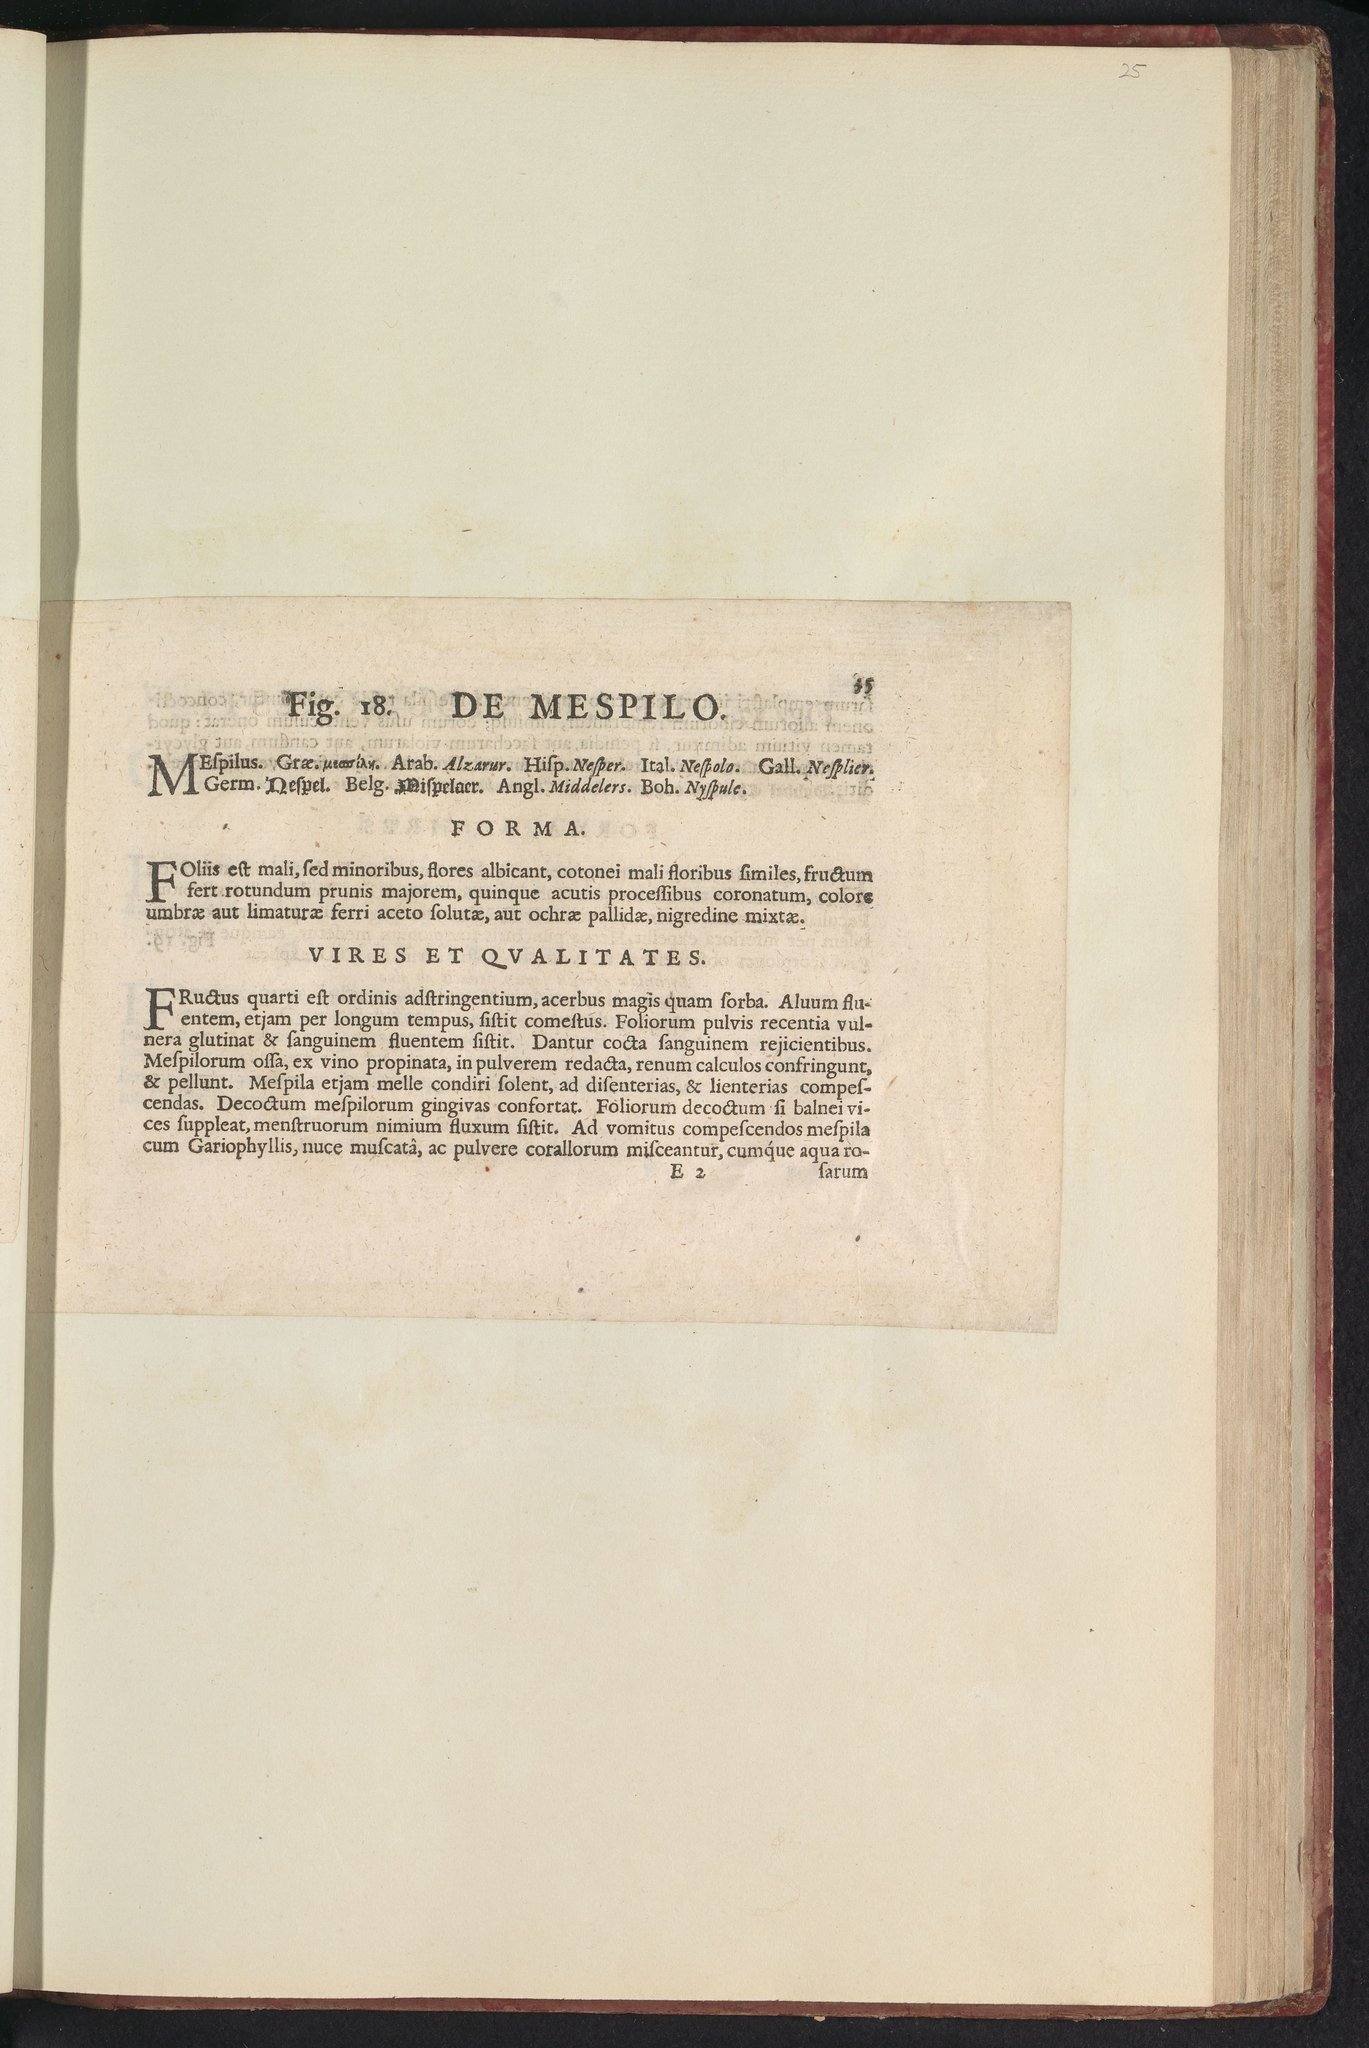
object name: text sheet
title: Fig. 18 'De Mespilo' in De Boodts herbarium van 1640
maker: anselmus boëtius de boodt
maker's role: draughtsman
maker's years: 1550-1632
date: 1640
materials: ink, paper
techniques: letterpress printing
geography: bruges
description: Beschrijving bij Fig. 18 op p. 35 in: Anselmi Boëtii de Boot I.C. Brugensis & Rodolphi II. Imp. Roman. medici a cubiculis Florum, Herbarum, ac fructuum selectiorum icones, & vires pleraeque hactenus ignotæ. Onderdeel van het album met bladen en platen uit De Boodts herbarium van 1640. Het twaalfde van twaalf albums met aquarellen van dieren, vogels en planten bekend rond 1600, gemaakt in opdracht van keizer Rudolf II.